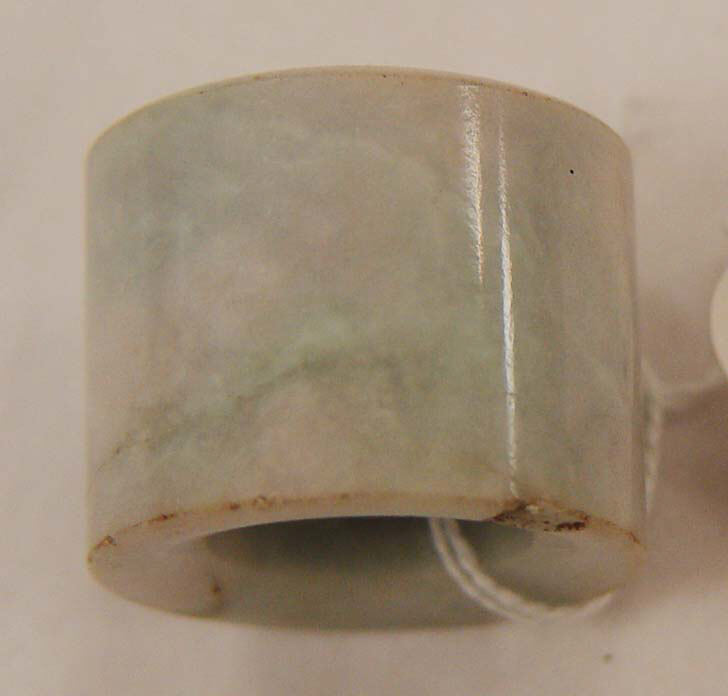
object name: ring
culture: chinese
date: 1801-1900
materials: jade